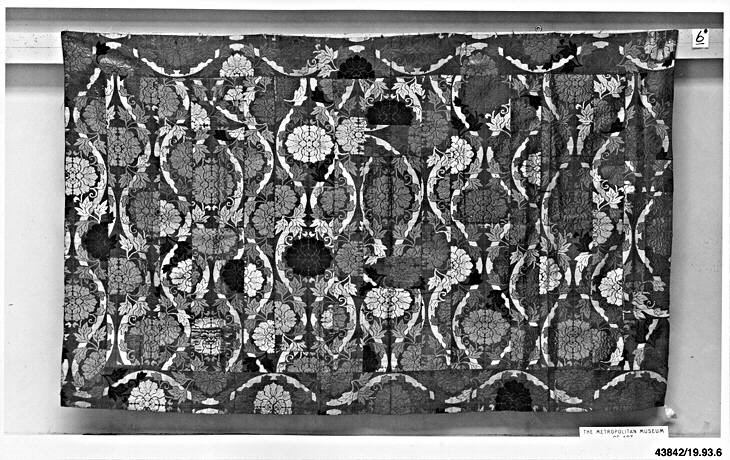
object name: robe, priest's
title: Seven-Panel Buddhist Monk’s Vestment (Shichijō kesa) with Peony Patterns in Undulating Columns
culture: japanese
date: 1701-1733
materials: silk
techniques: patterning, weave